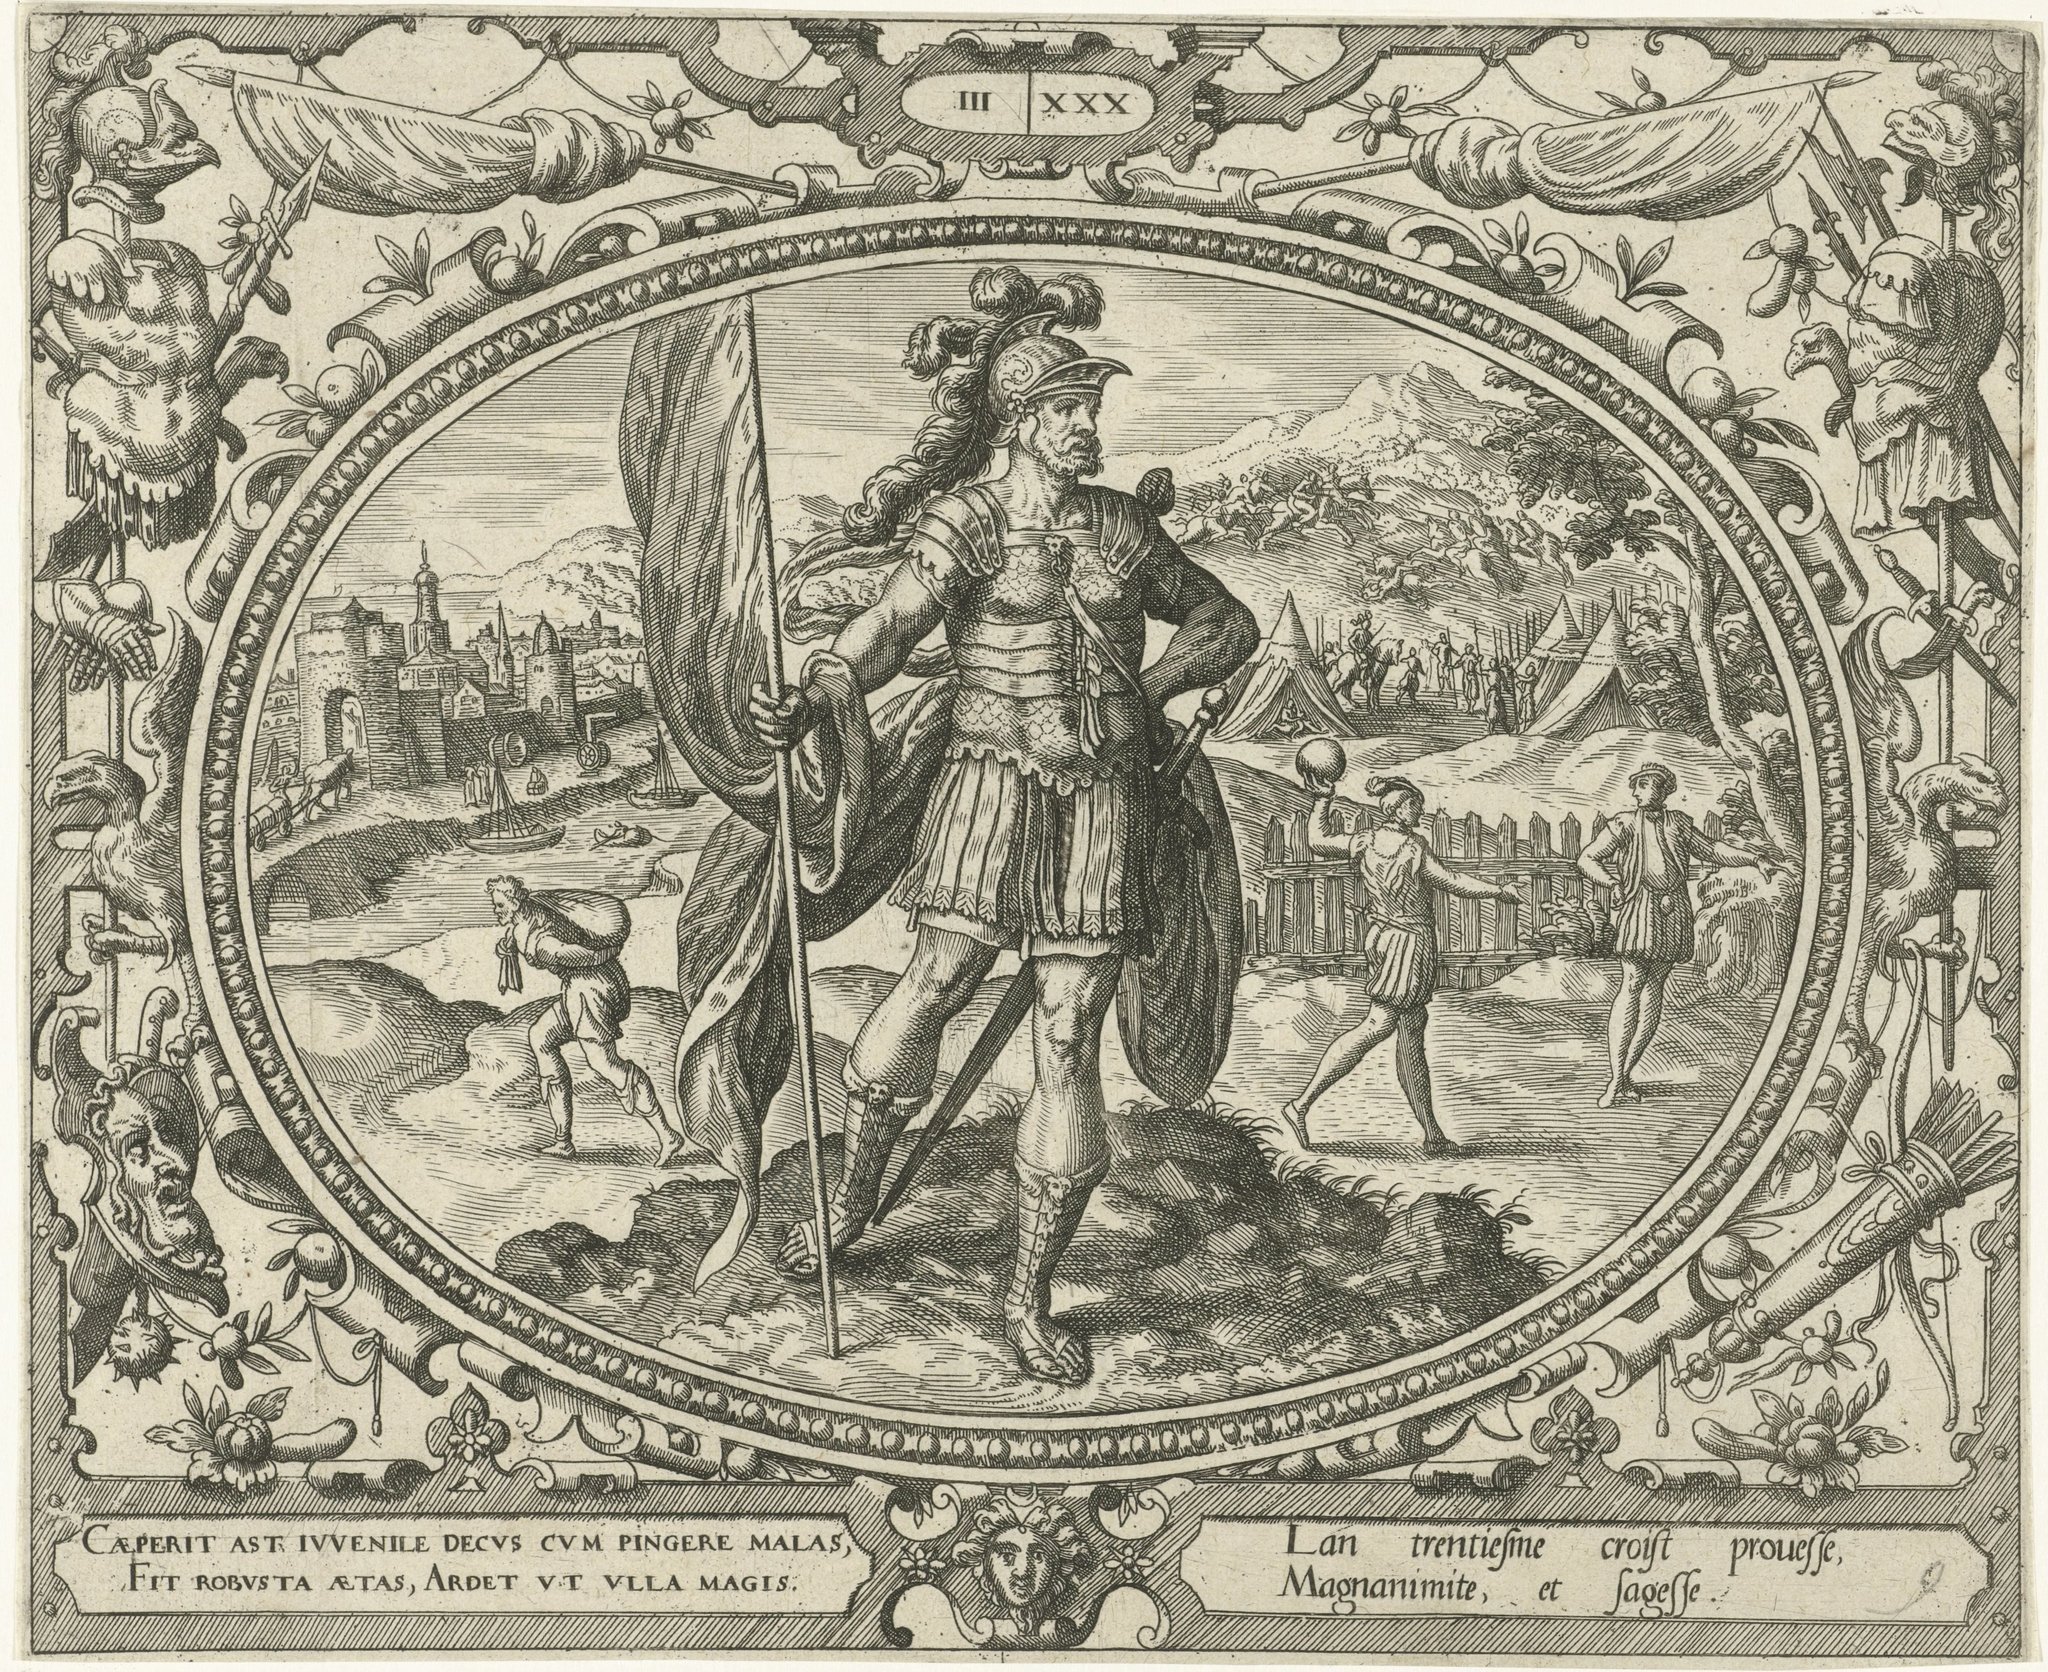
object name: print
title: Tien leeftijden van de mens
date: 1569-1575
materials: paper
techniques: engraving, etching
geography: antwerp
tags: (military) camp with tents, adult man, wandering or travelling merchant, the soldier; the soldier's life, ball-throwing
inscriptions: collector's mark: Lugt 2228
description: In een ovaal kader versierd met ornamenten een voorstelling van een volwassen man in wapenrusting. In zijn handen een vaandel. Op de achtergrond rechts een legerkamp en enkele mannen die een balspel spelen. Op de achtergrond links een zakkensjouwer en een handelsstad. De prent heeft een Latijns en Frans onderschrift.